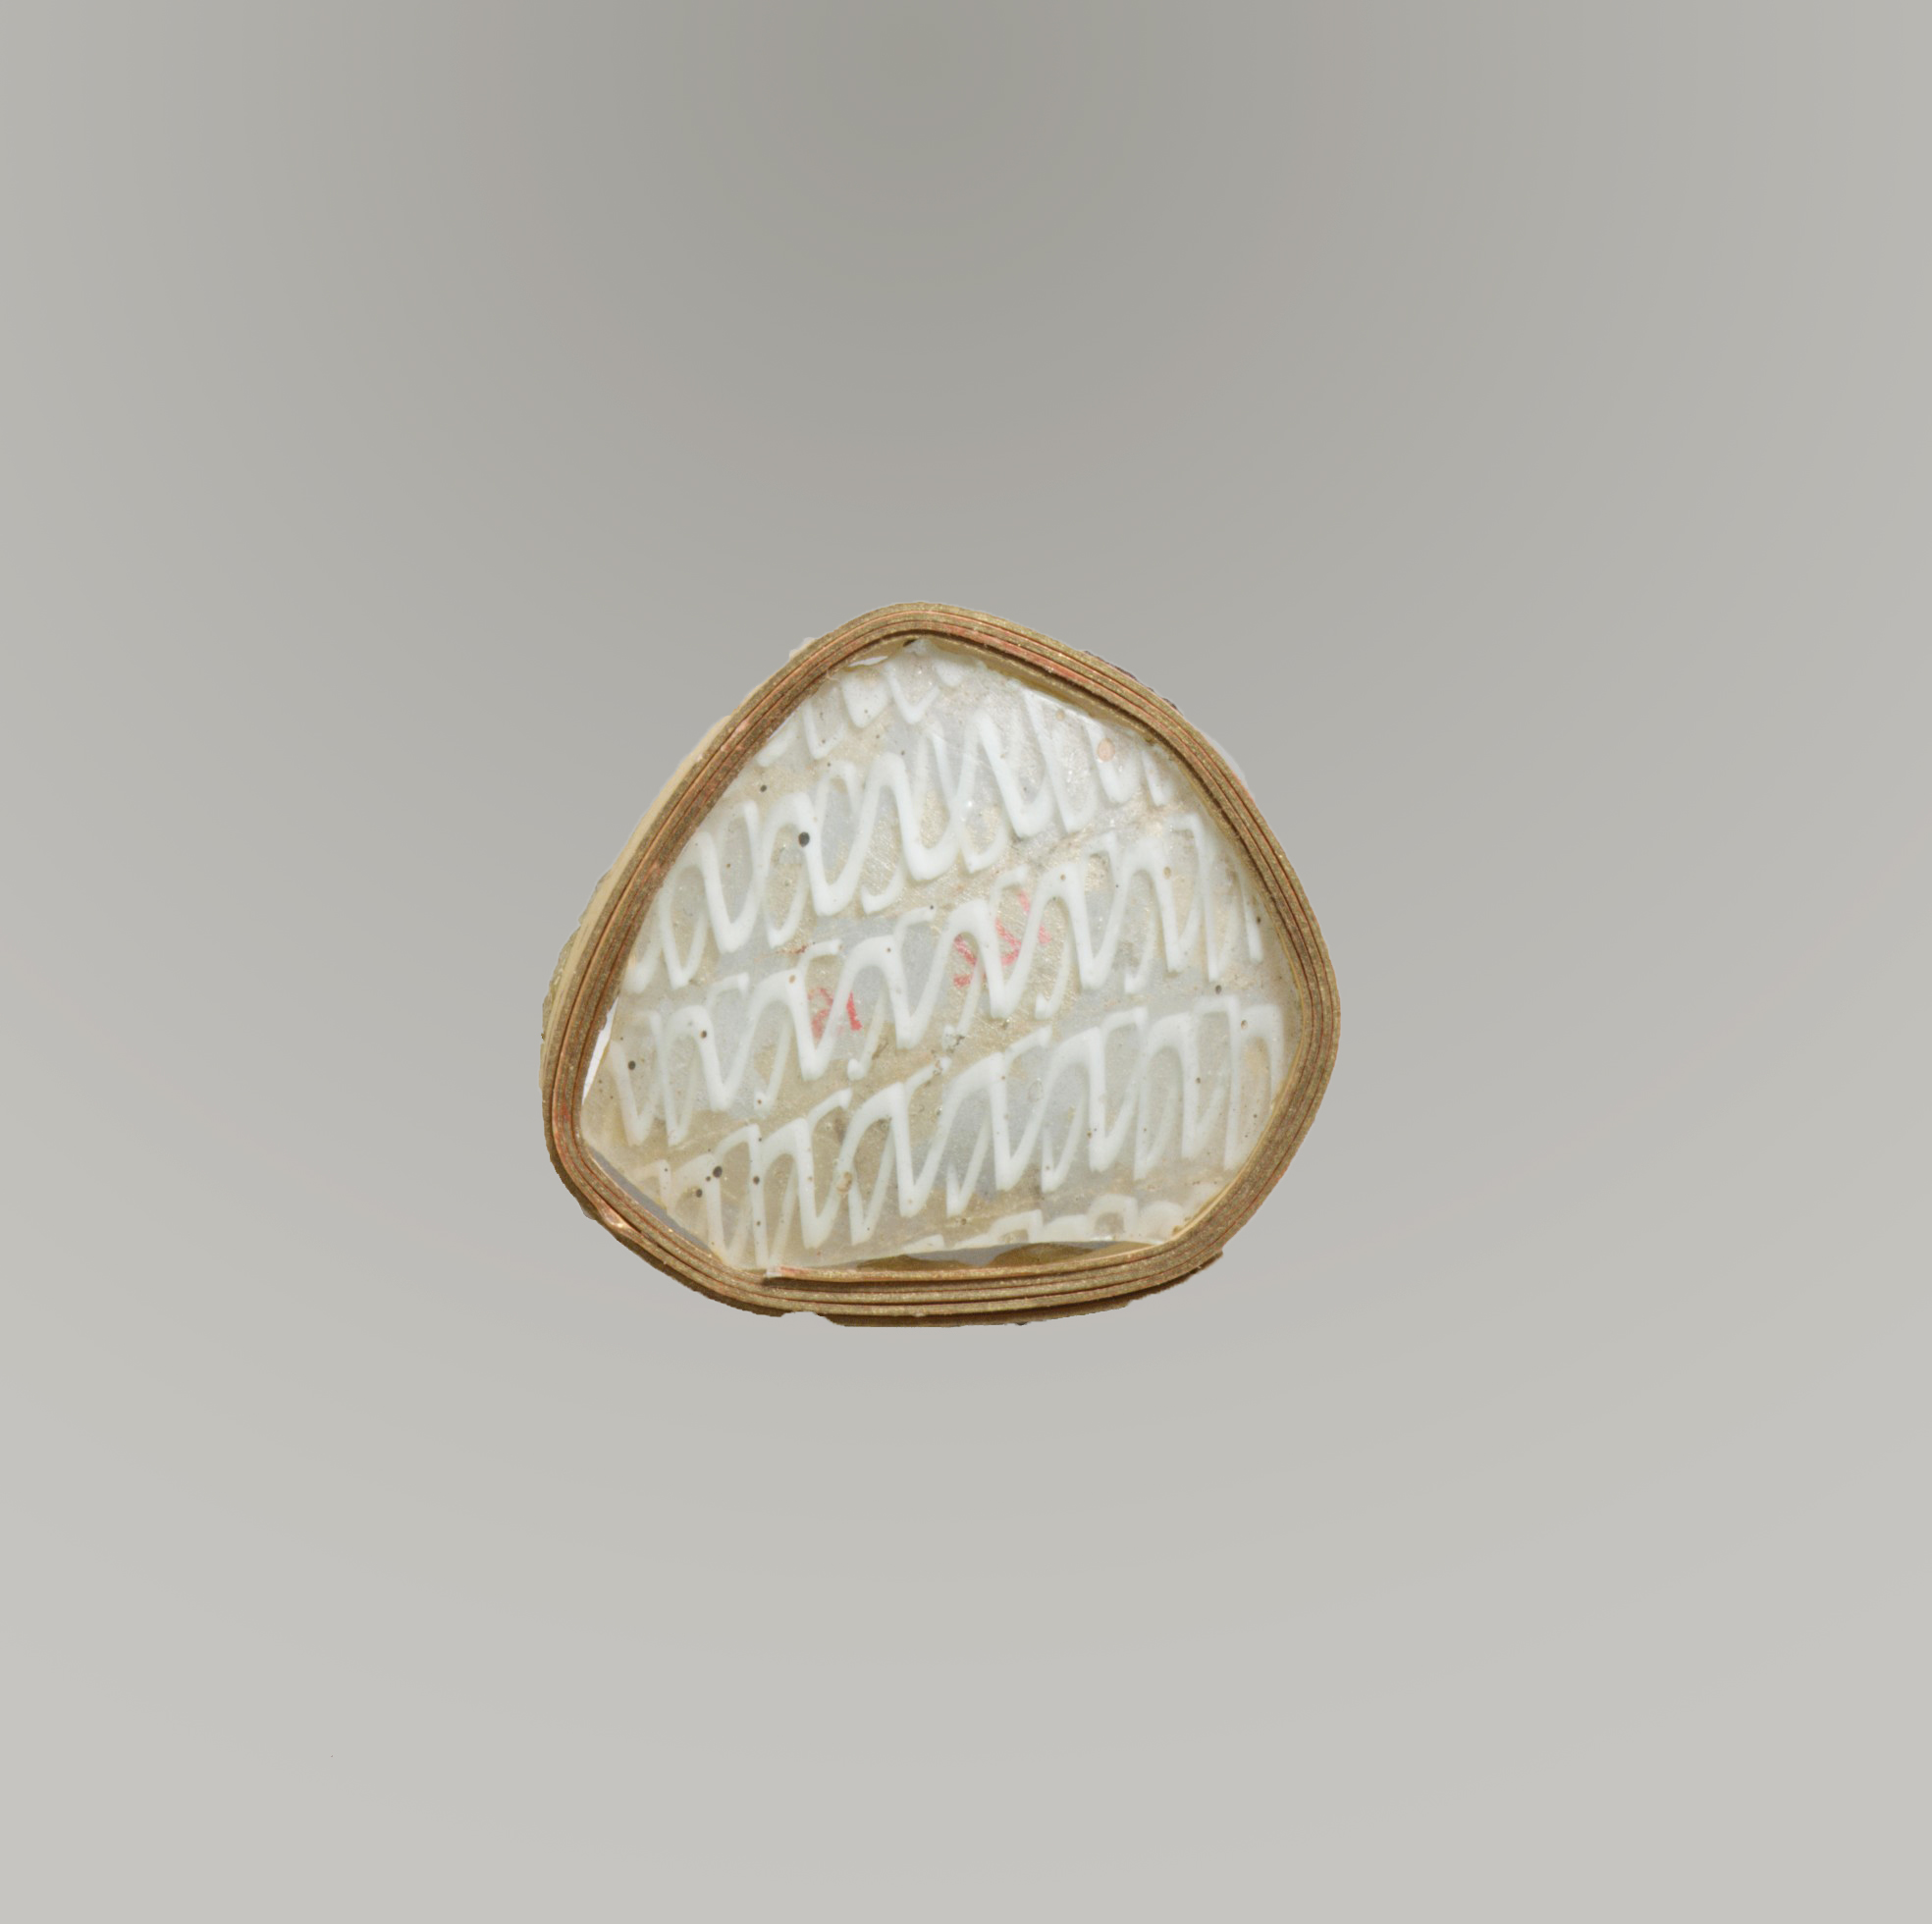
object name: fragment, network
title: Glass network mosaic fragment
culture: roman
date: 34 BCE-33 CE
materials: glass